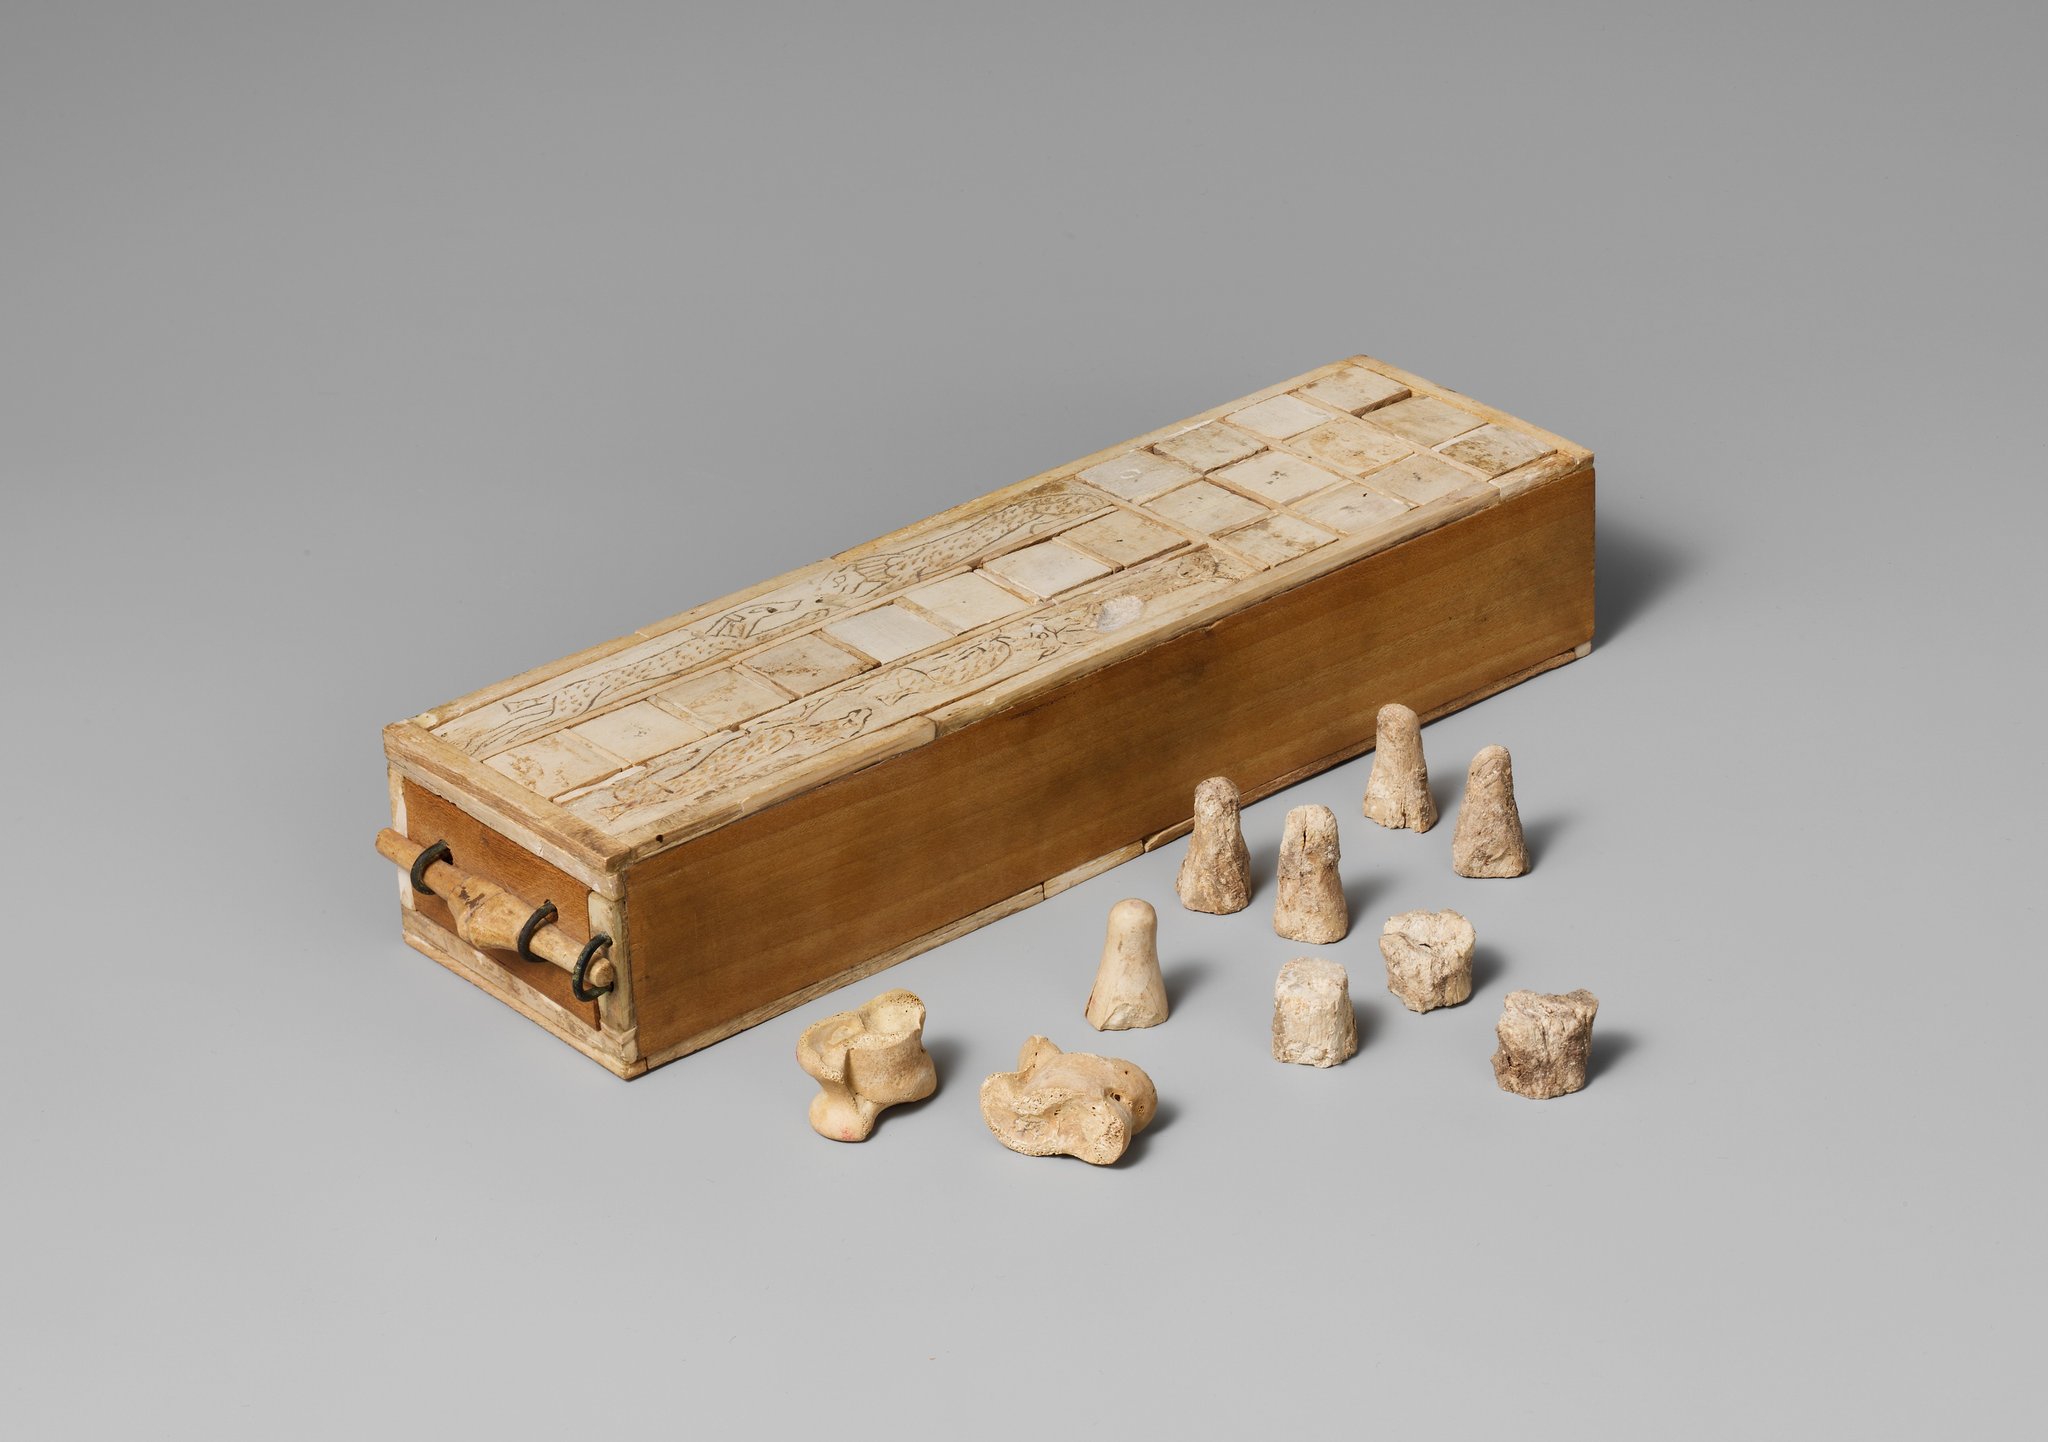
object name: game box, senet, gazelle, hound, lion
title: Game Box for Playing Senet and Twenty Squares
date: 1635-1458 BCE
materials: copper alloy, ivory, wood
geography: egypt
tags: games